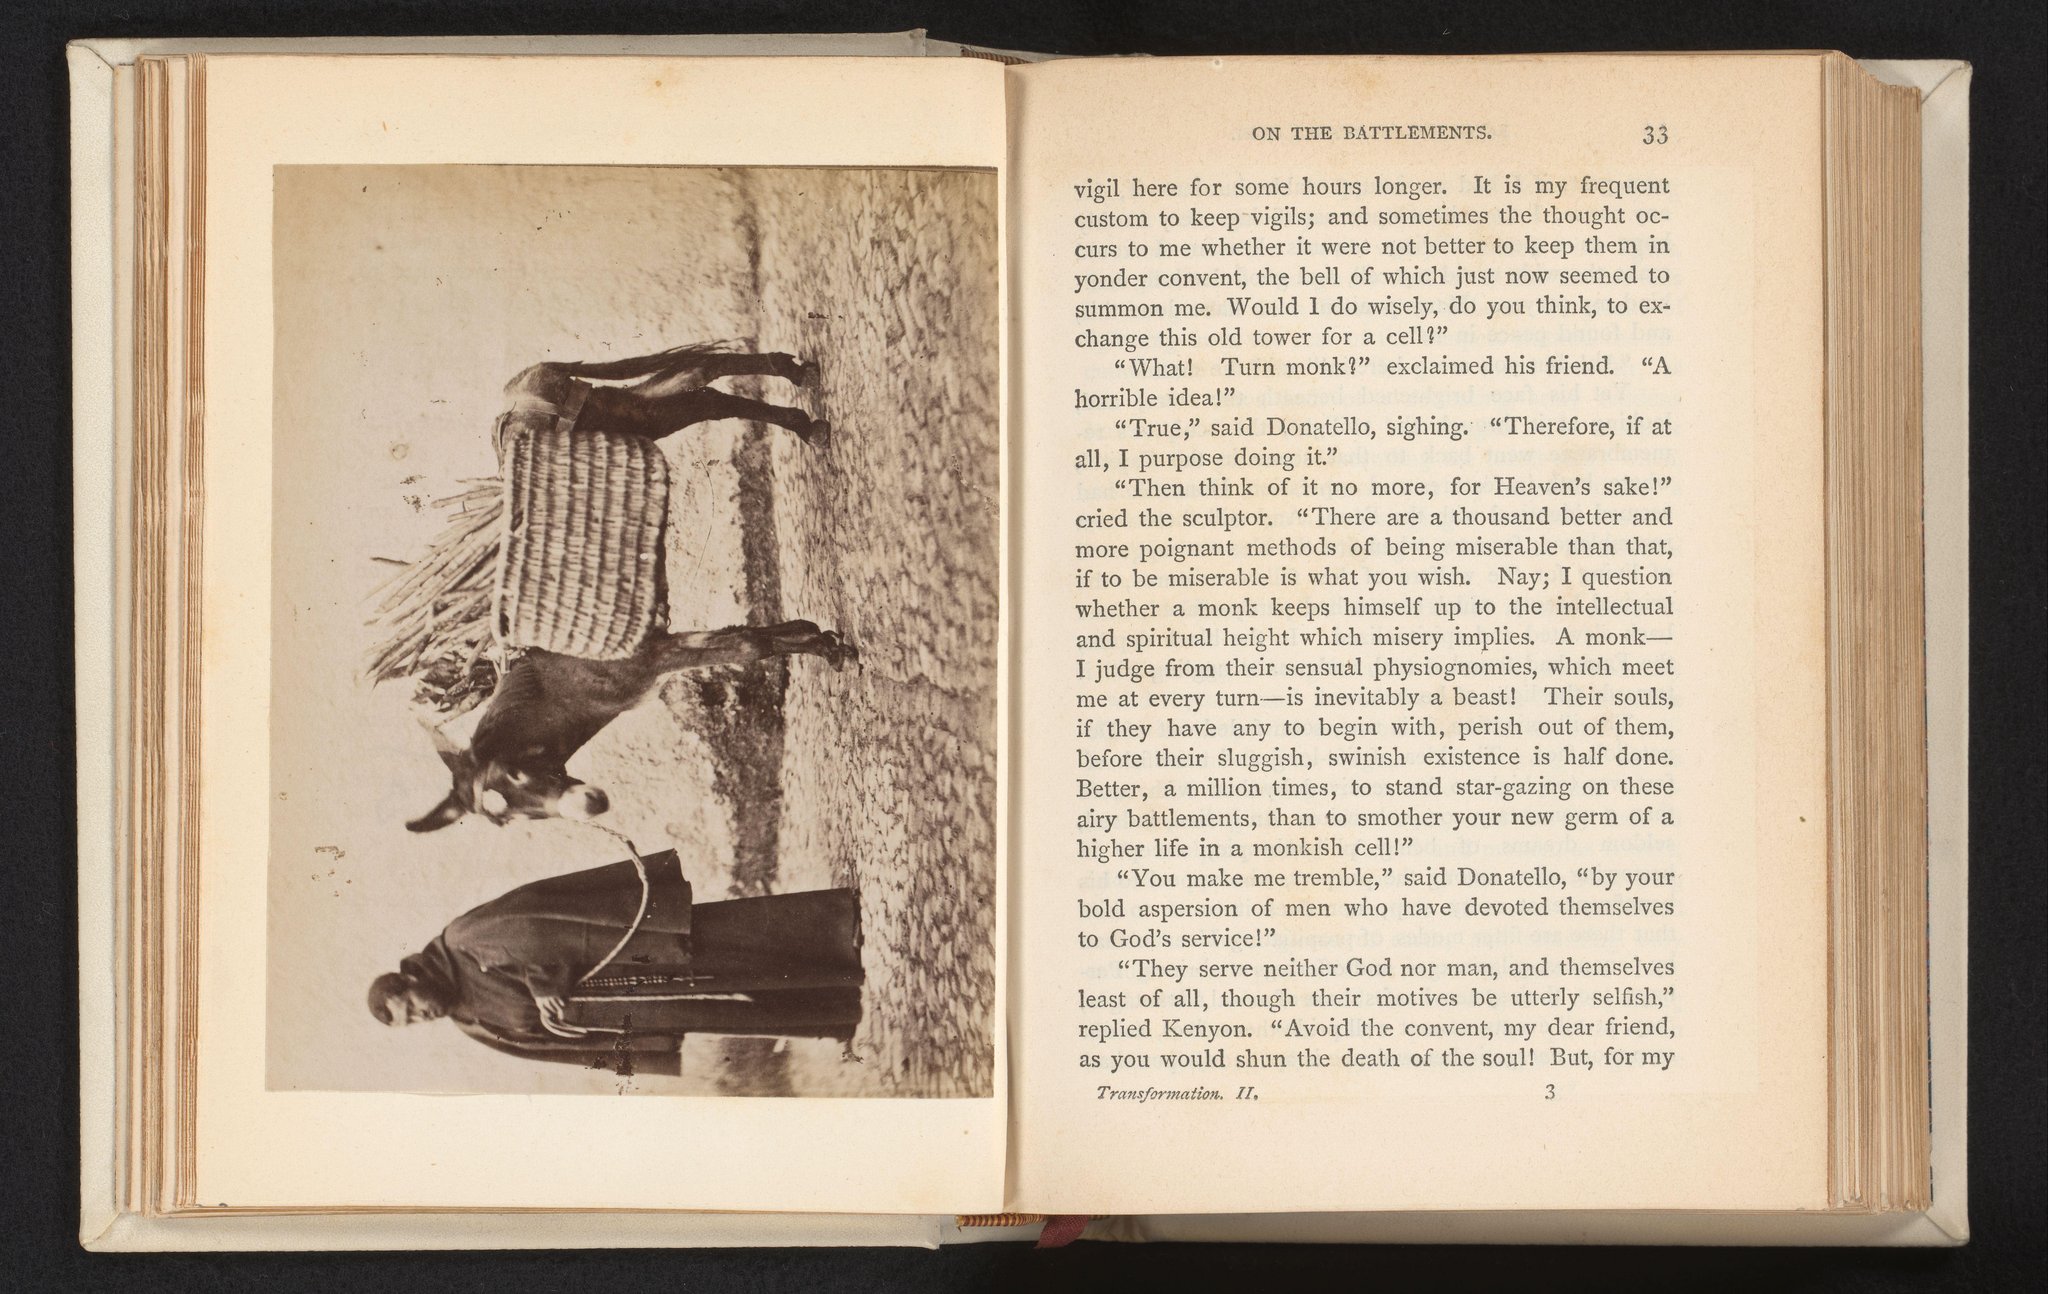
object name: page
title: Portret van een monnik met een ezel op straat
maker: Anonymous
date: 1850-1860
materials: photographic support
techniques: albumen print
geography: italy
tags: ass, donkey, monk(s), friar(s)